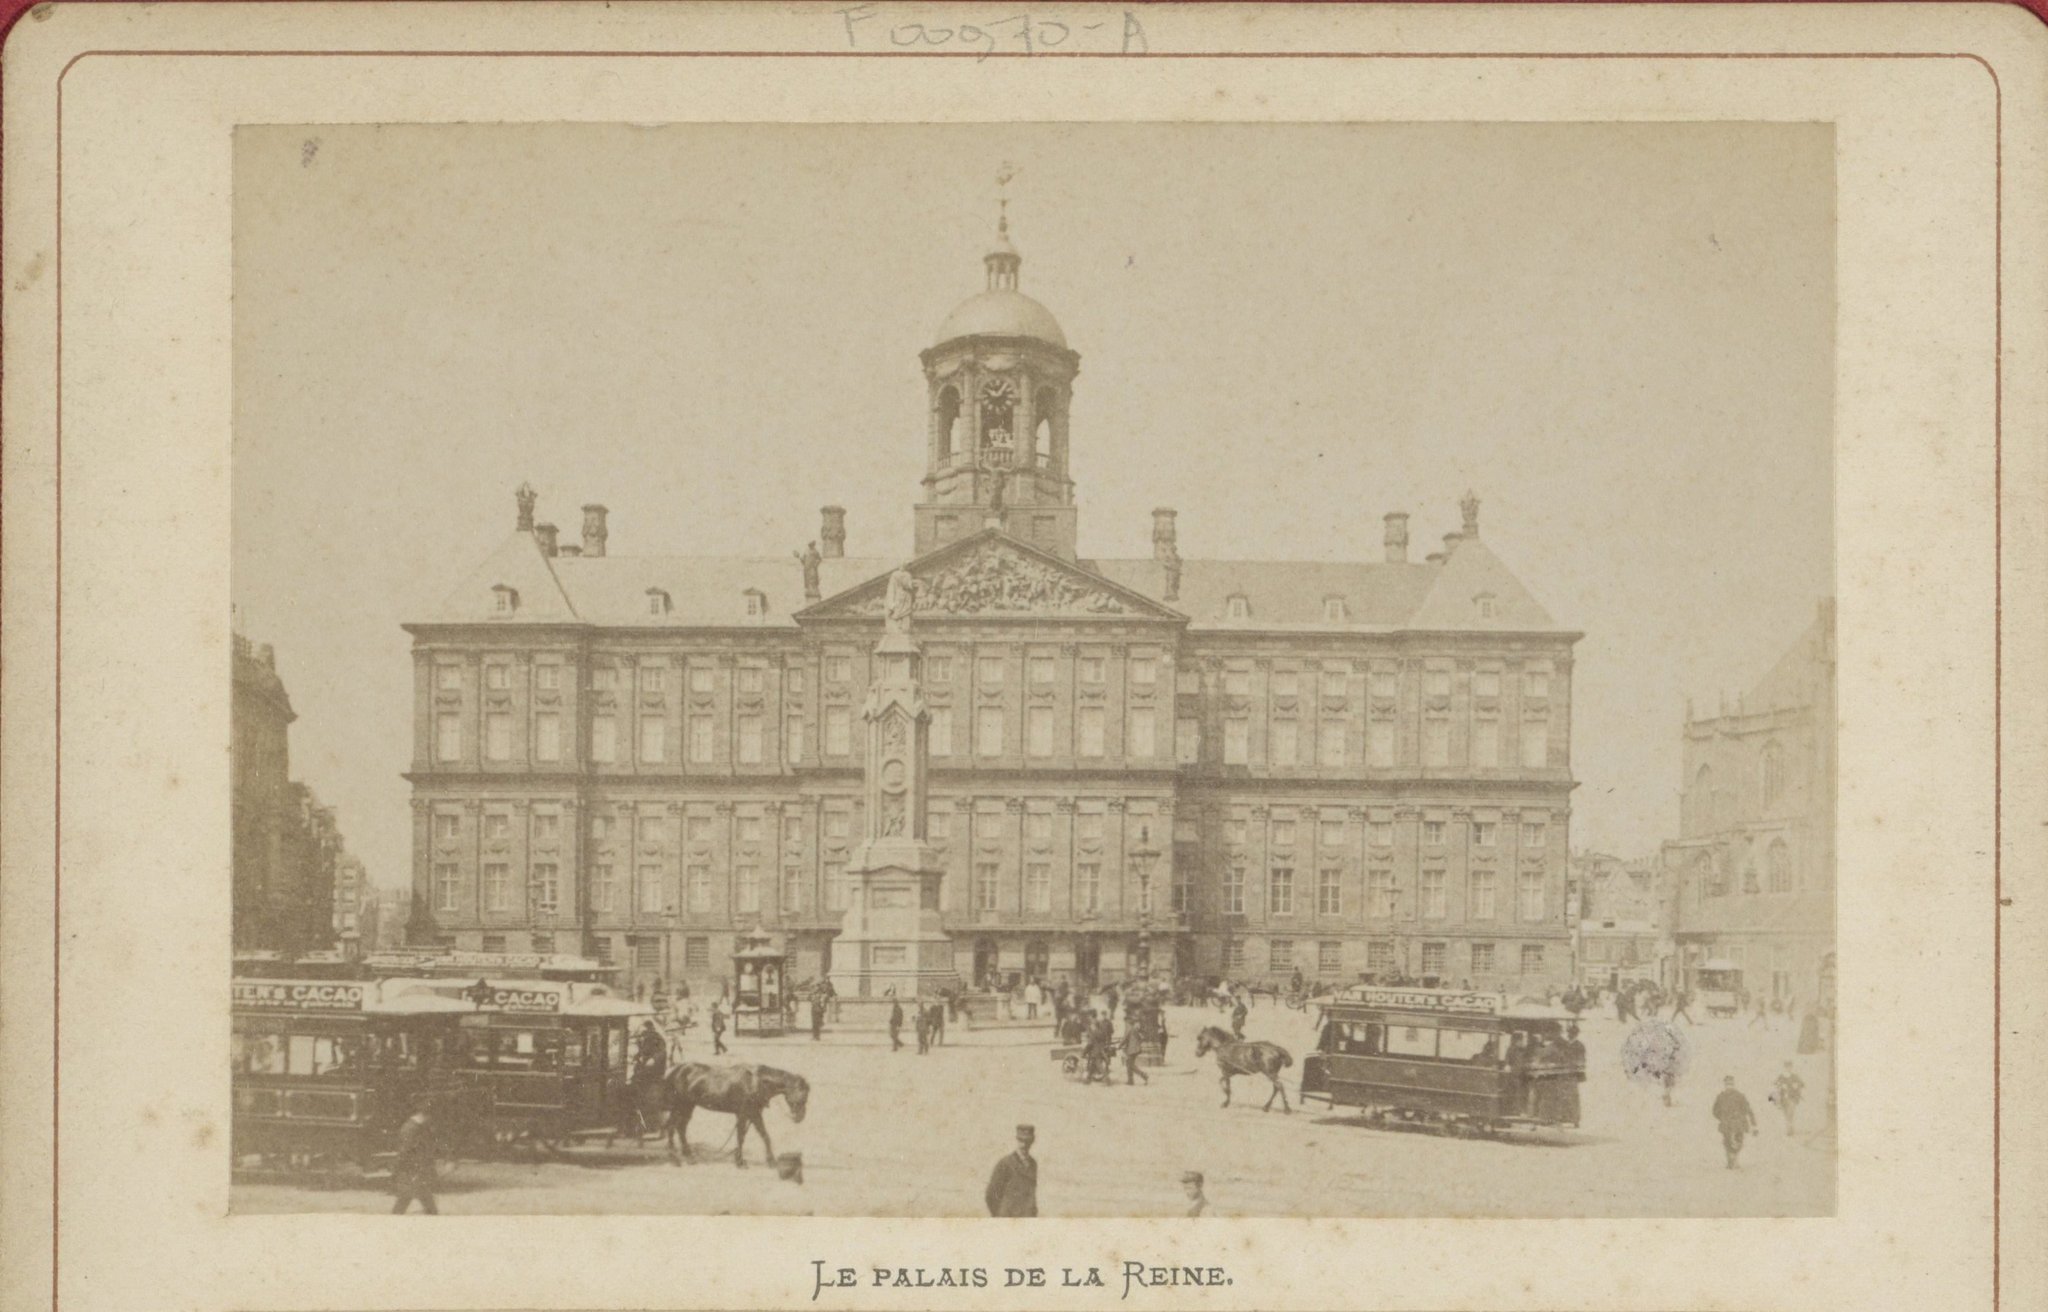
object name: photograph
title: Gezicht op de Dam in Amsterdam met het Koninklijk Paleis, 'Naatje' en paardentrams en voorbijgangers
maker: andries jager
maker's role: publisher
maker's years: 1825-1905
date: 1877-1910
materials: cardboard, paper, photographic support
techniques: albumen print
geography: amsterdam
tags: diligence, omnibus, horse-tram, palace, monument, statue, square, place, circus, etc. (+ city(-scape) with figures, staffage), royal palace of amsterdam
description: Onderdeel van Leporelloalbum met 28 foto's van Amsterdam en omstreken.